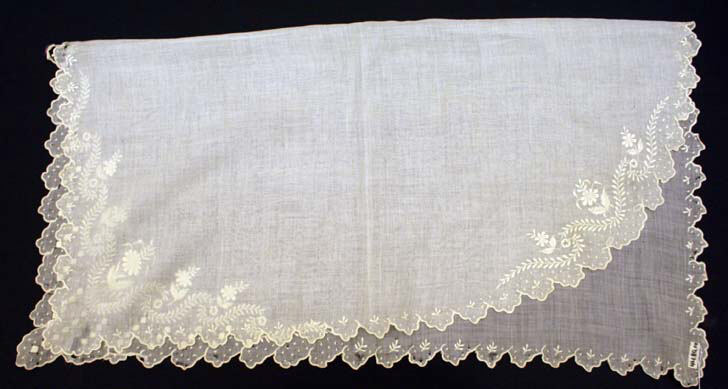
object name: kerchief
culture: american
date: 1860-1869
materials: cotton